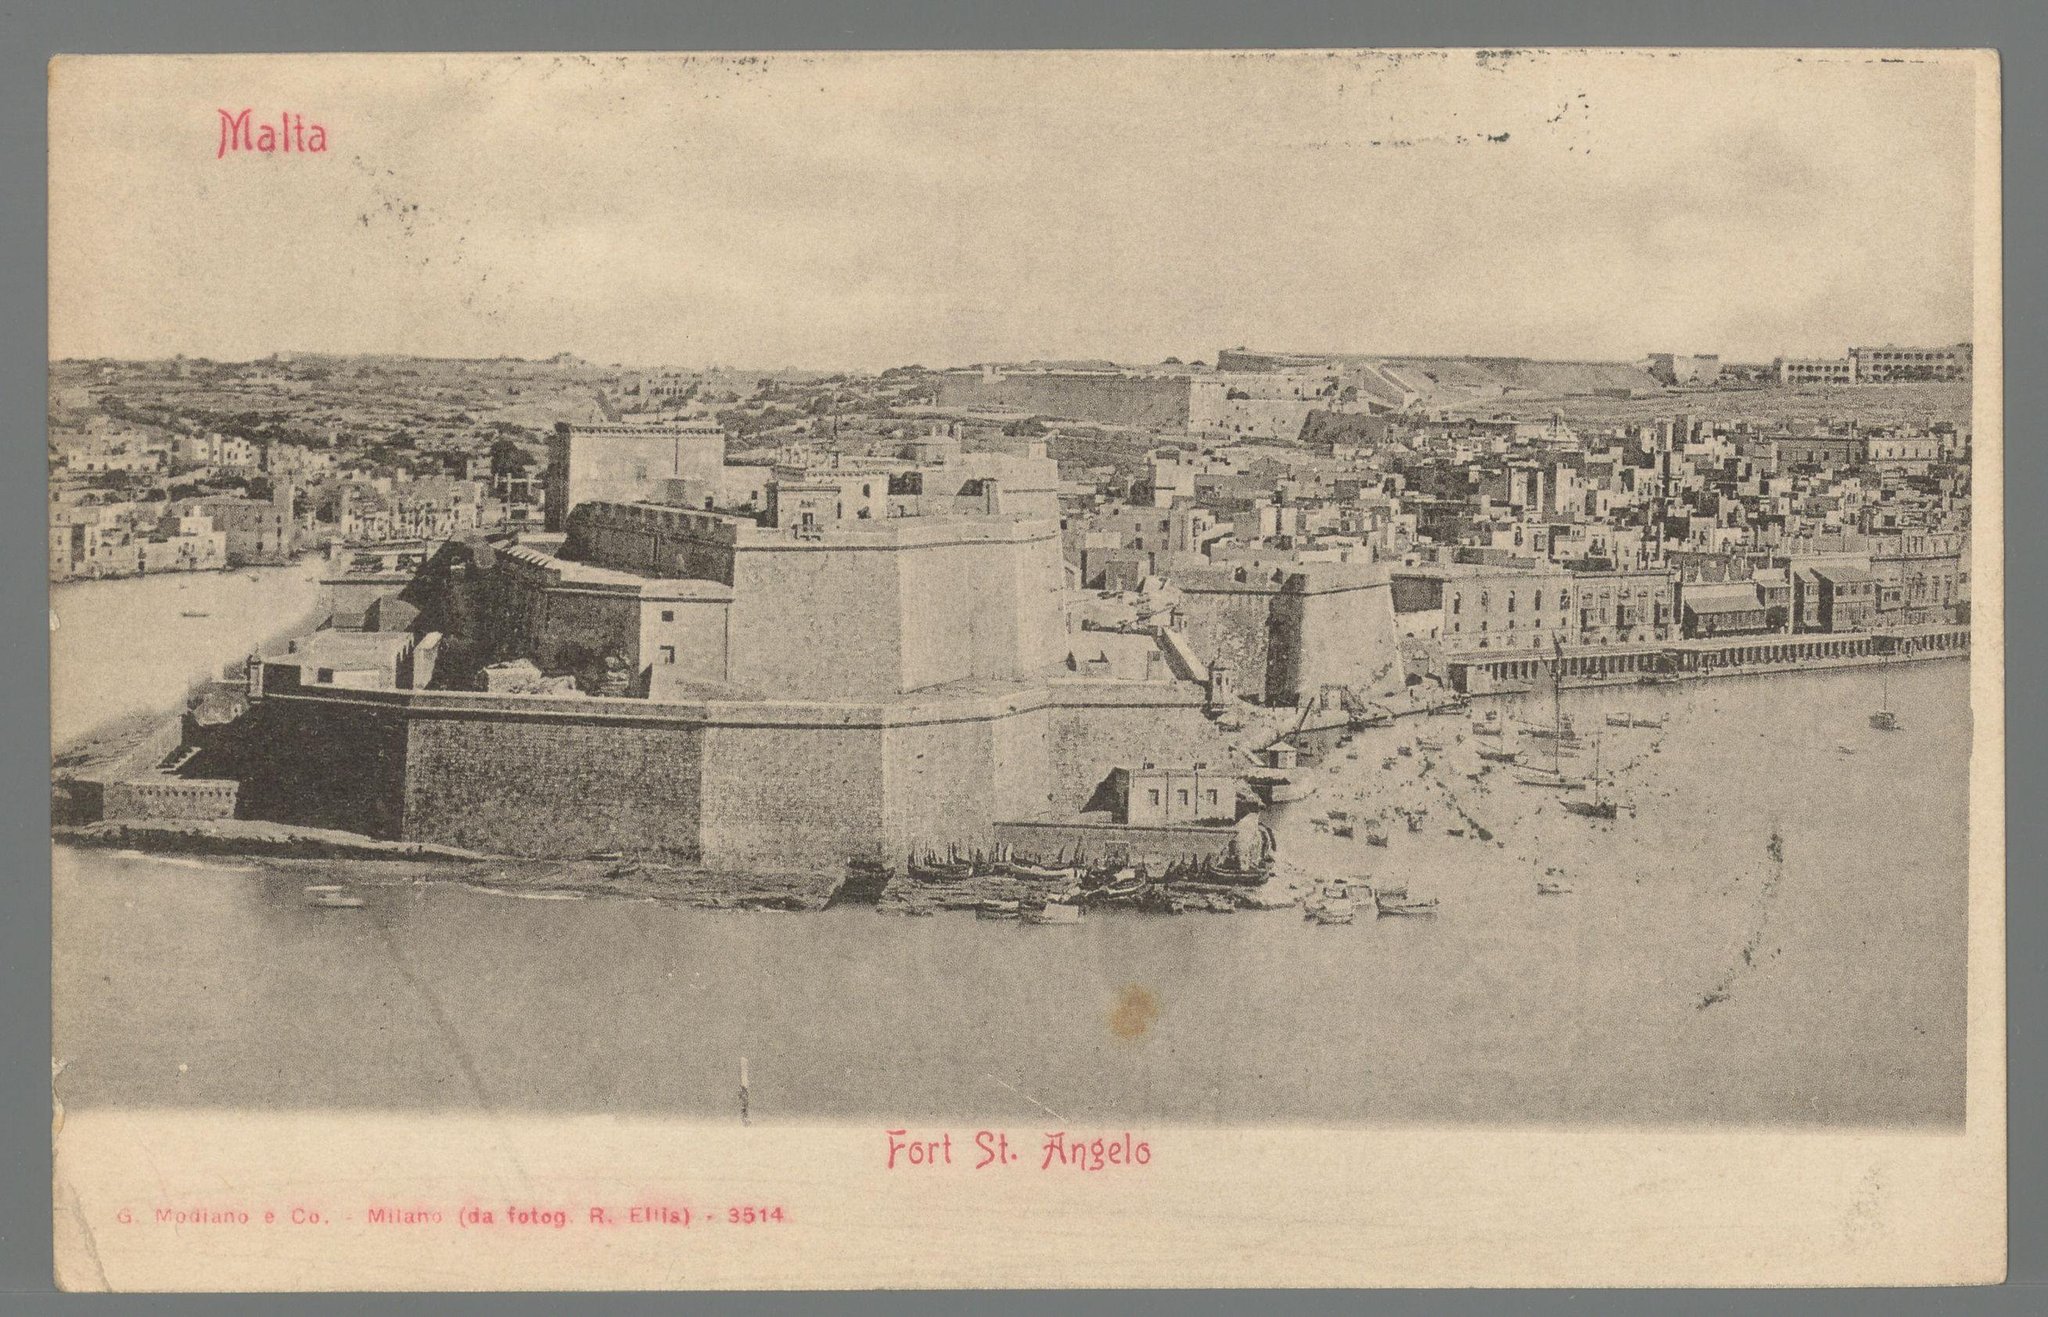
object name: photomechanical print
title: Malta. Fort St. Angelo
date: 1890-1903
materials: cardboard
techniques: photograph, writing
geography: malta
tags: fortress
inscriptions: poststempel, verso, gestempeld